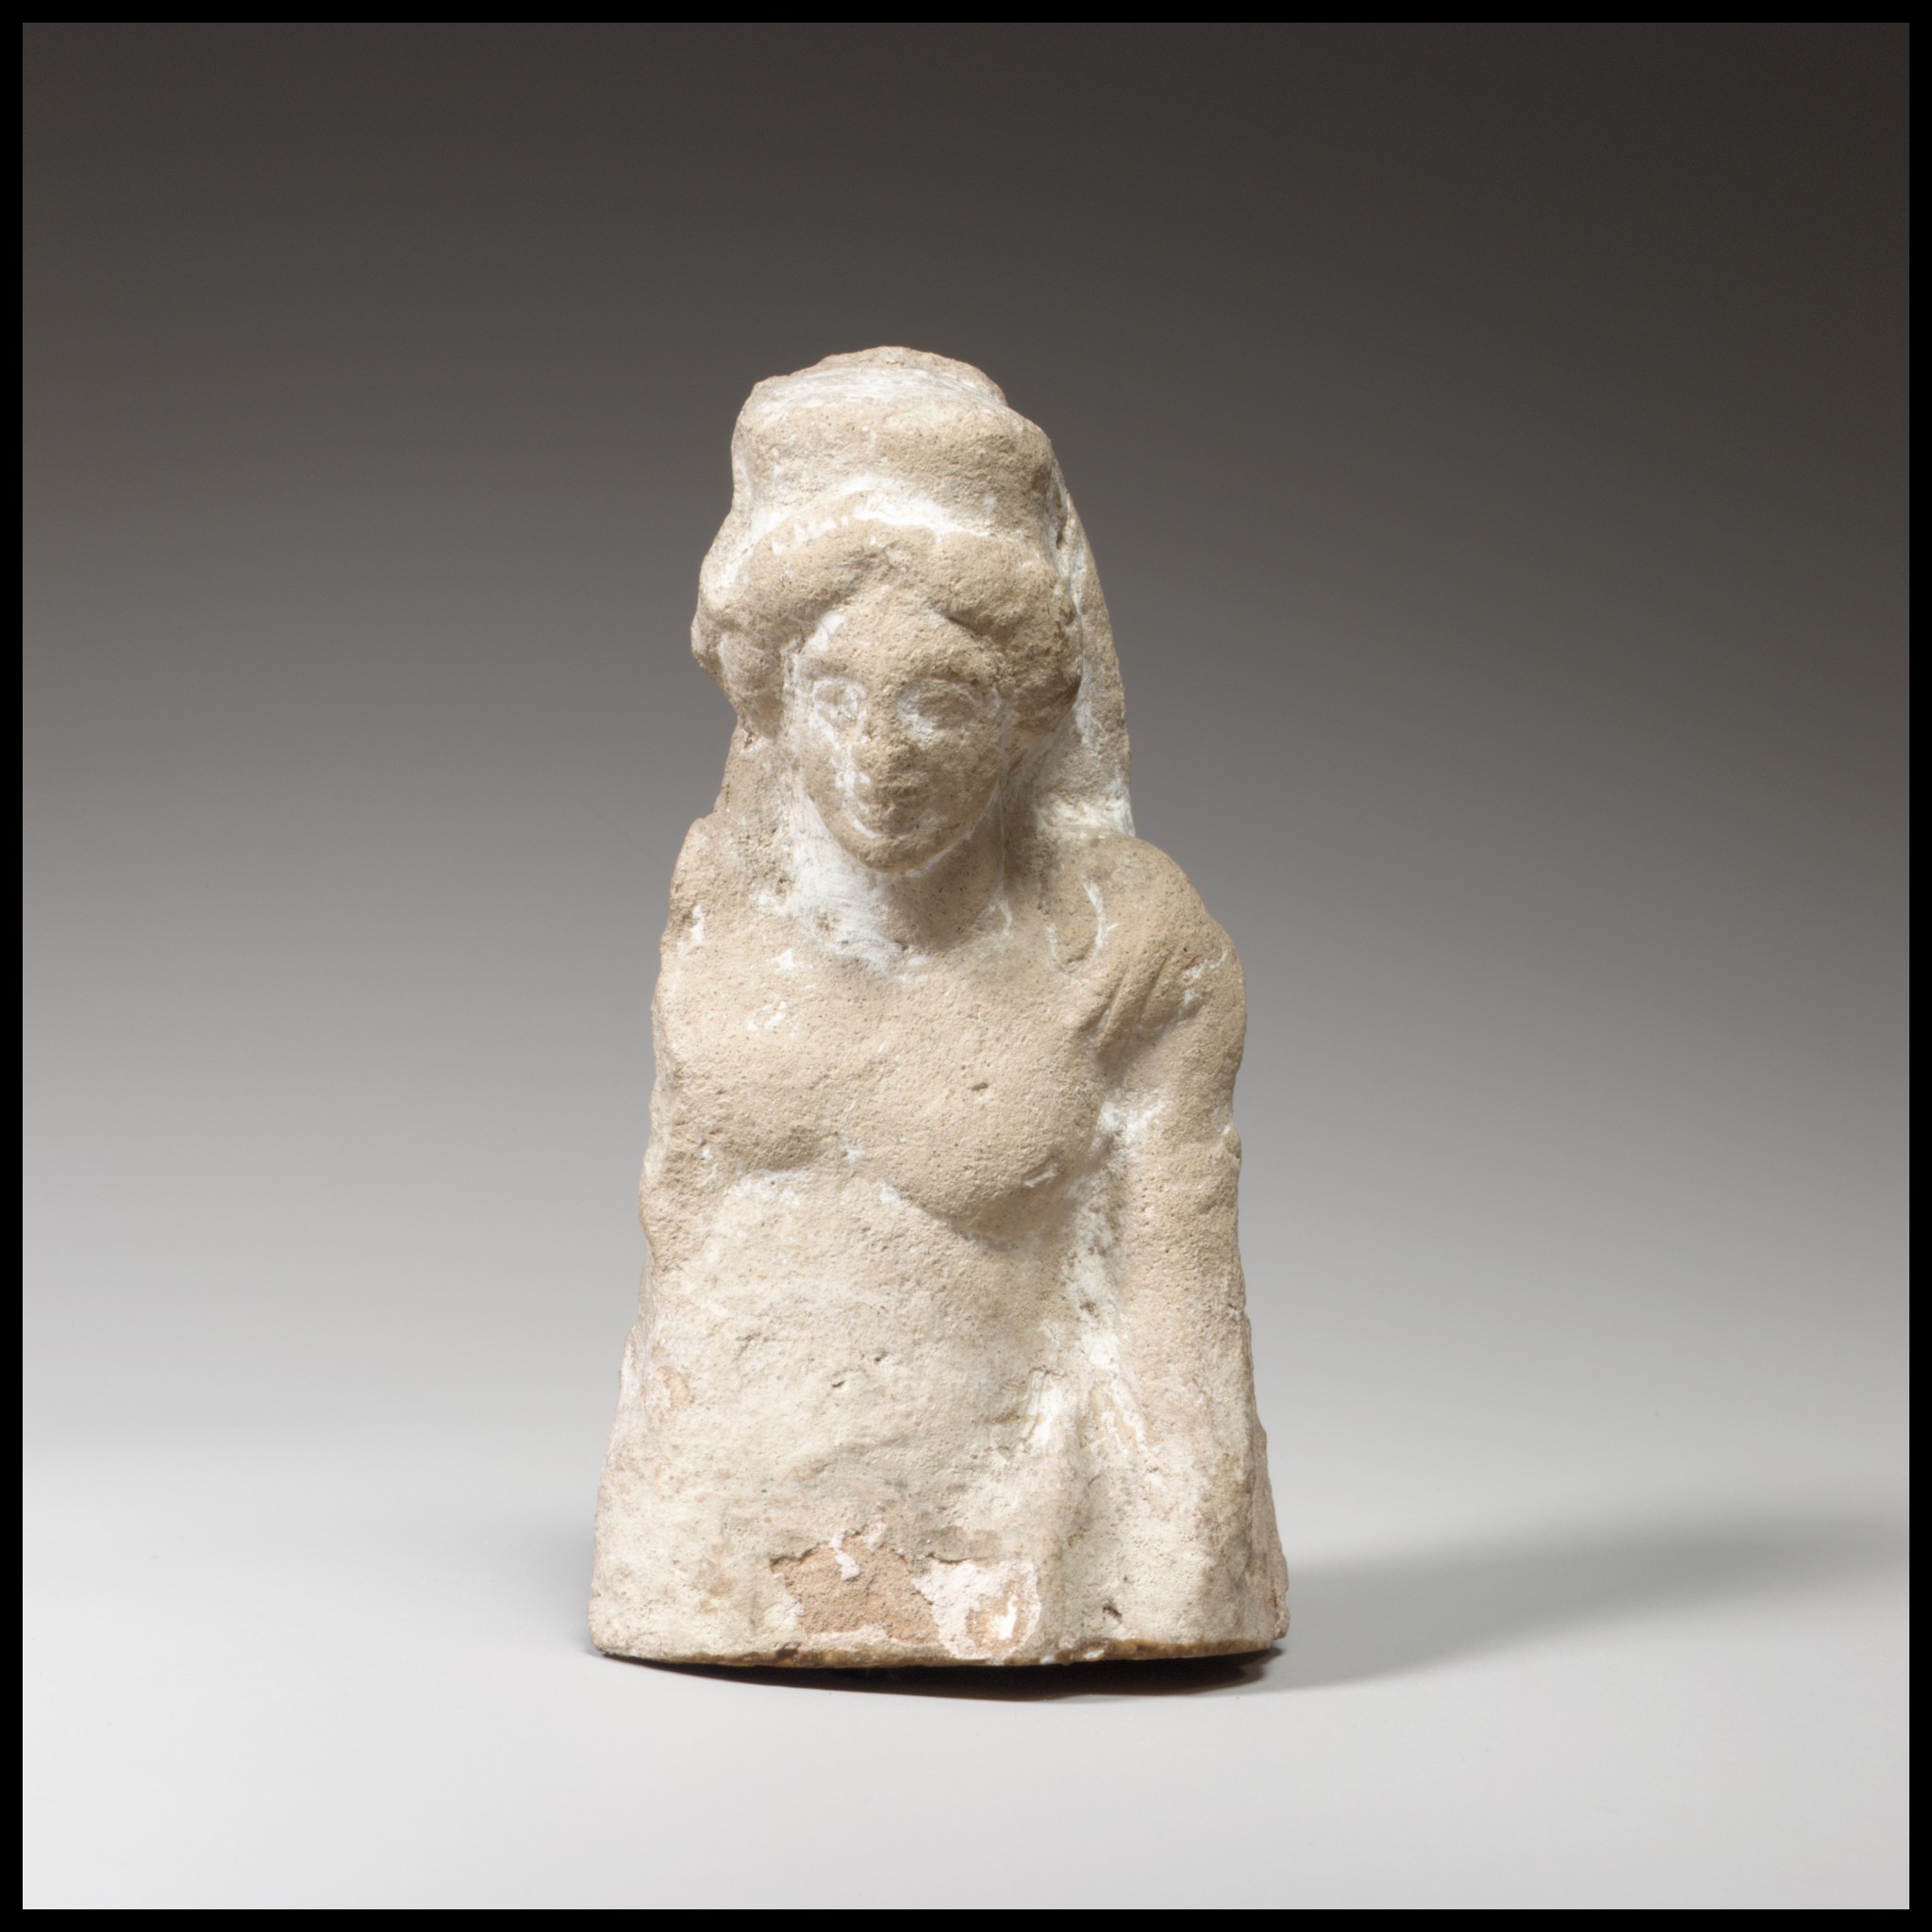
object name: statuette of psyche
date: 7000 BCE-330 CE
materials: terracotta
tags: psyche